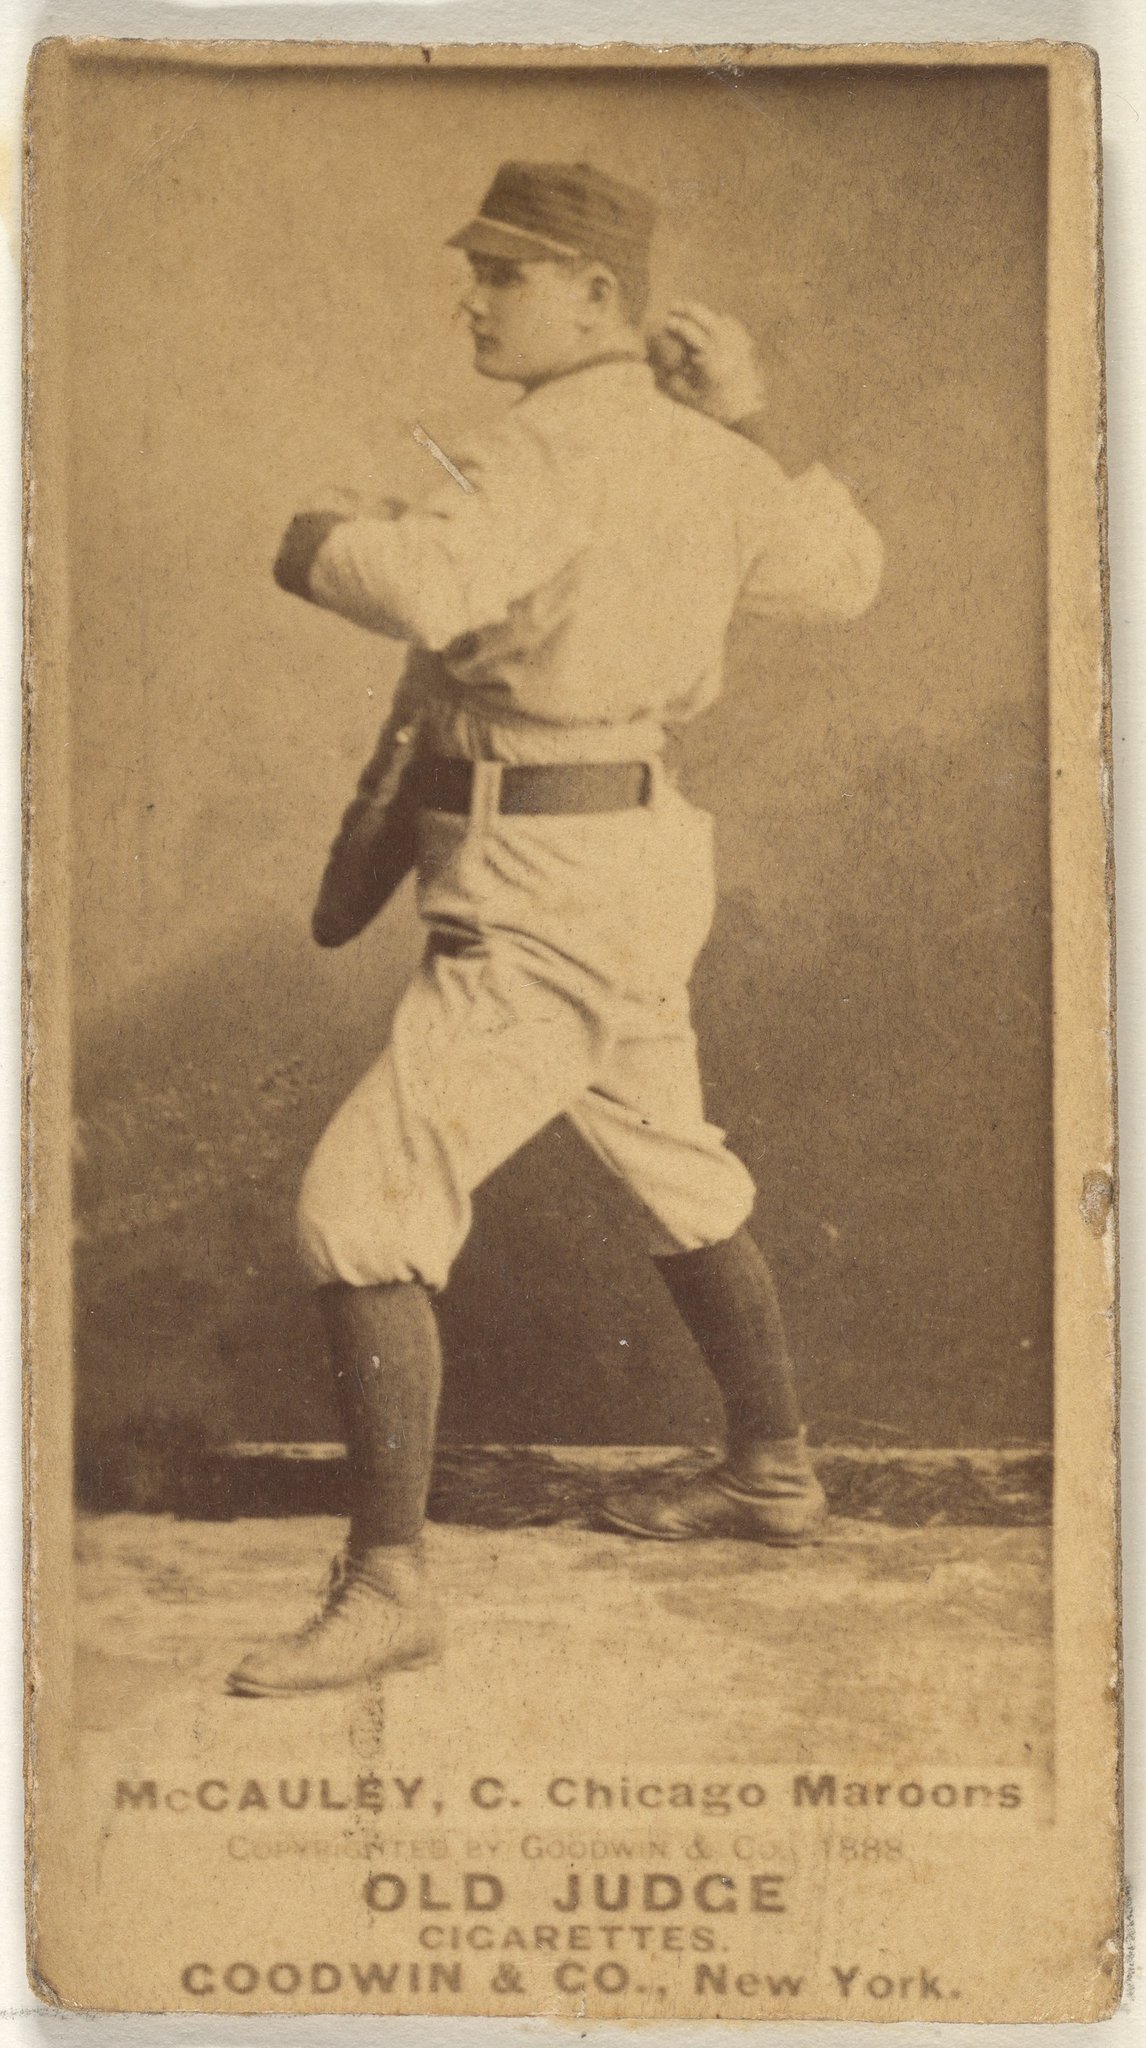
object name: baseball card, photograph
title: McCauley, Catcher, Chicago, from the Old Judge series (N172) for Old Judge Cigarettes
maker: goodwin & company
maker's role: publisher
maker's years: 1850-1950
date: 1888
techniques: albumen silver print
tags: men,portraits,baseball,athletes